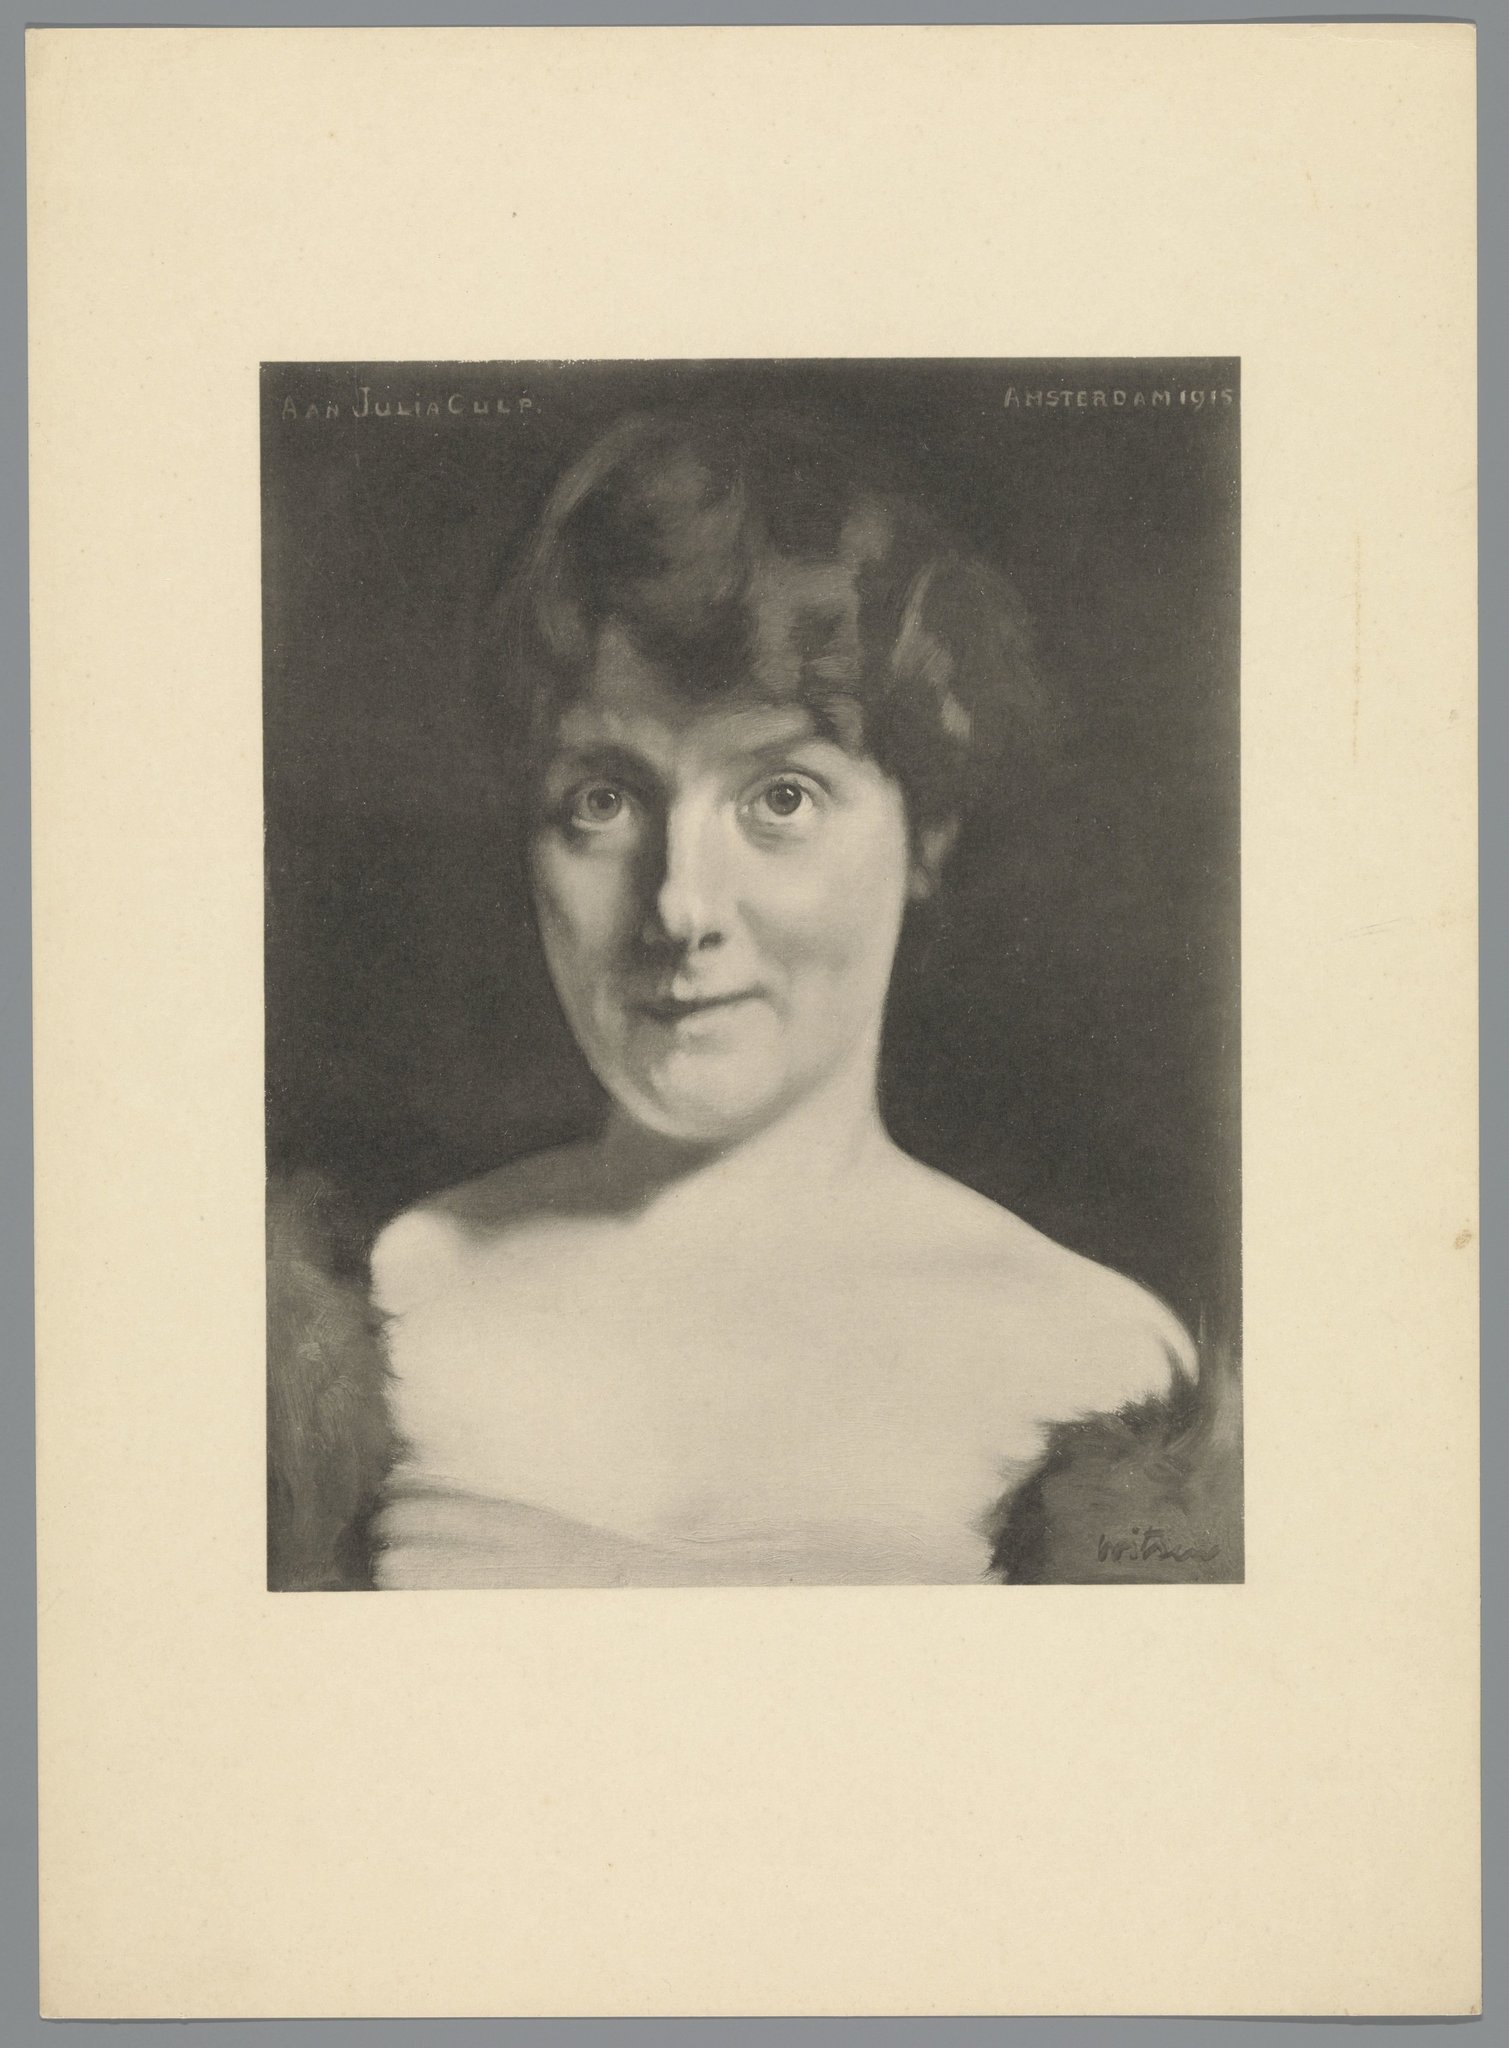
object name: print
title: Reproductie naar schilderij met portret van Julia Culp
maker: Anonymous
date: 1915-1925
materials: paper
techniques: photograph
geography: netherlands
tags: amsterdam